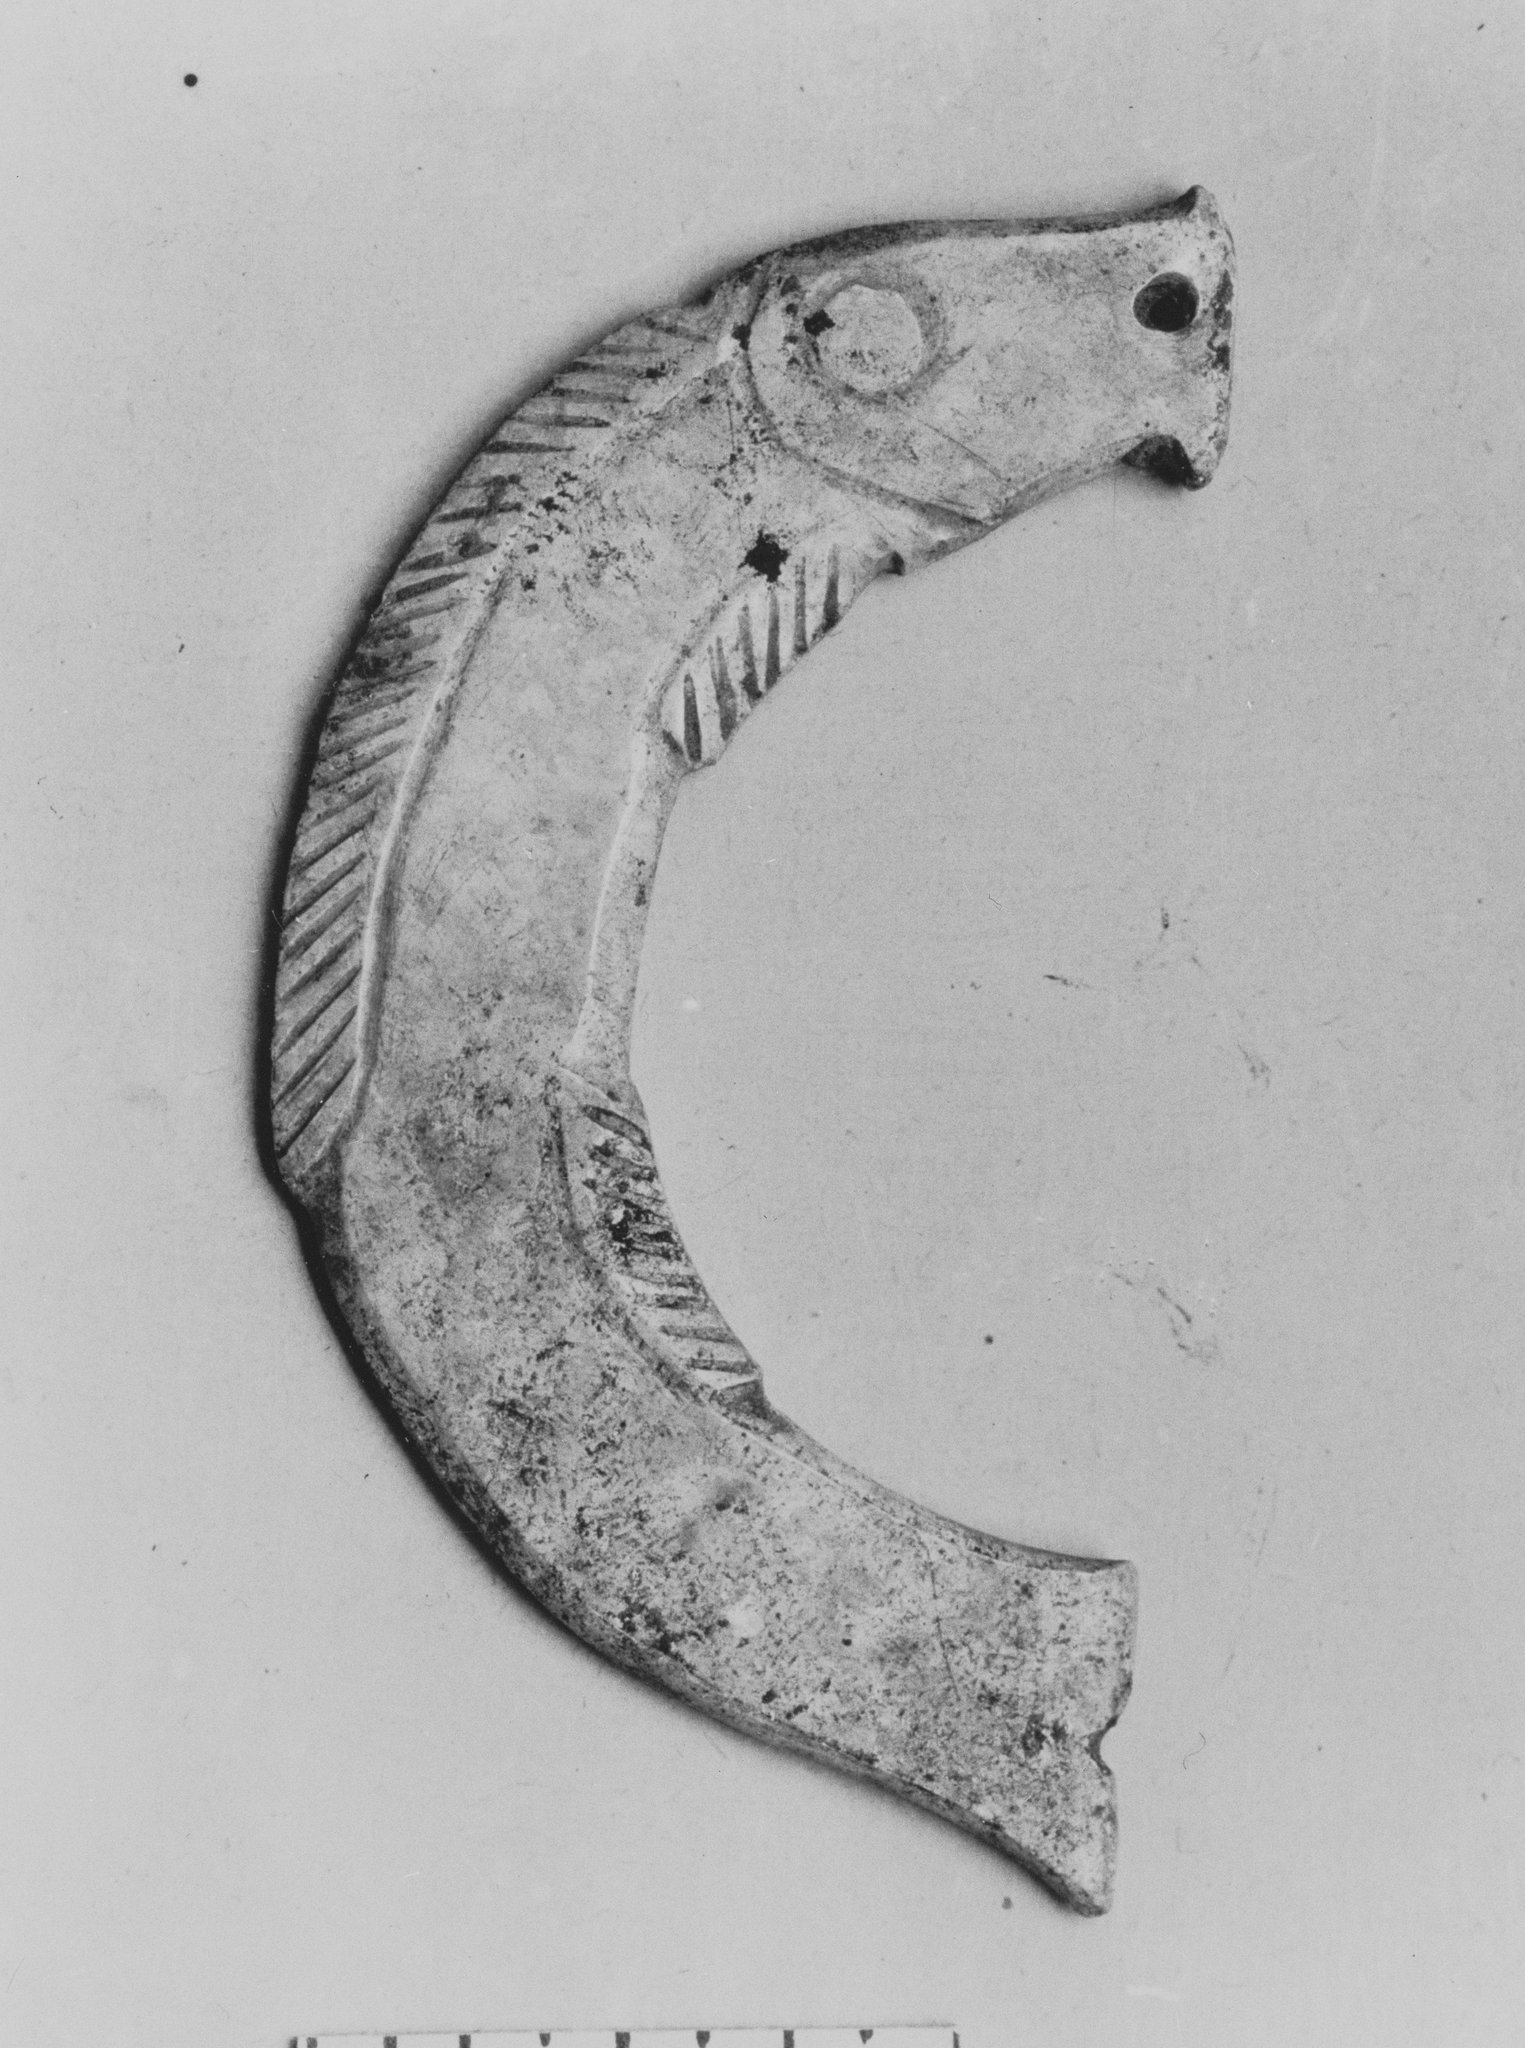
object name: plaque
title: Plaque in the shape of a fish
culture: chinese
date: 1600-771 BCE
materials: jade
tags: fish